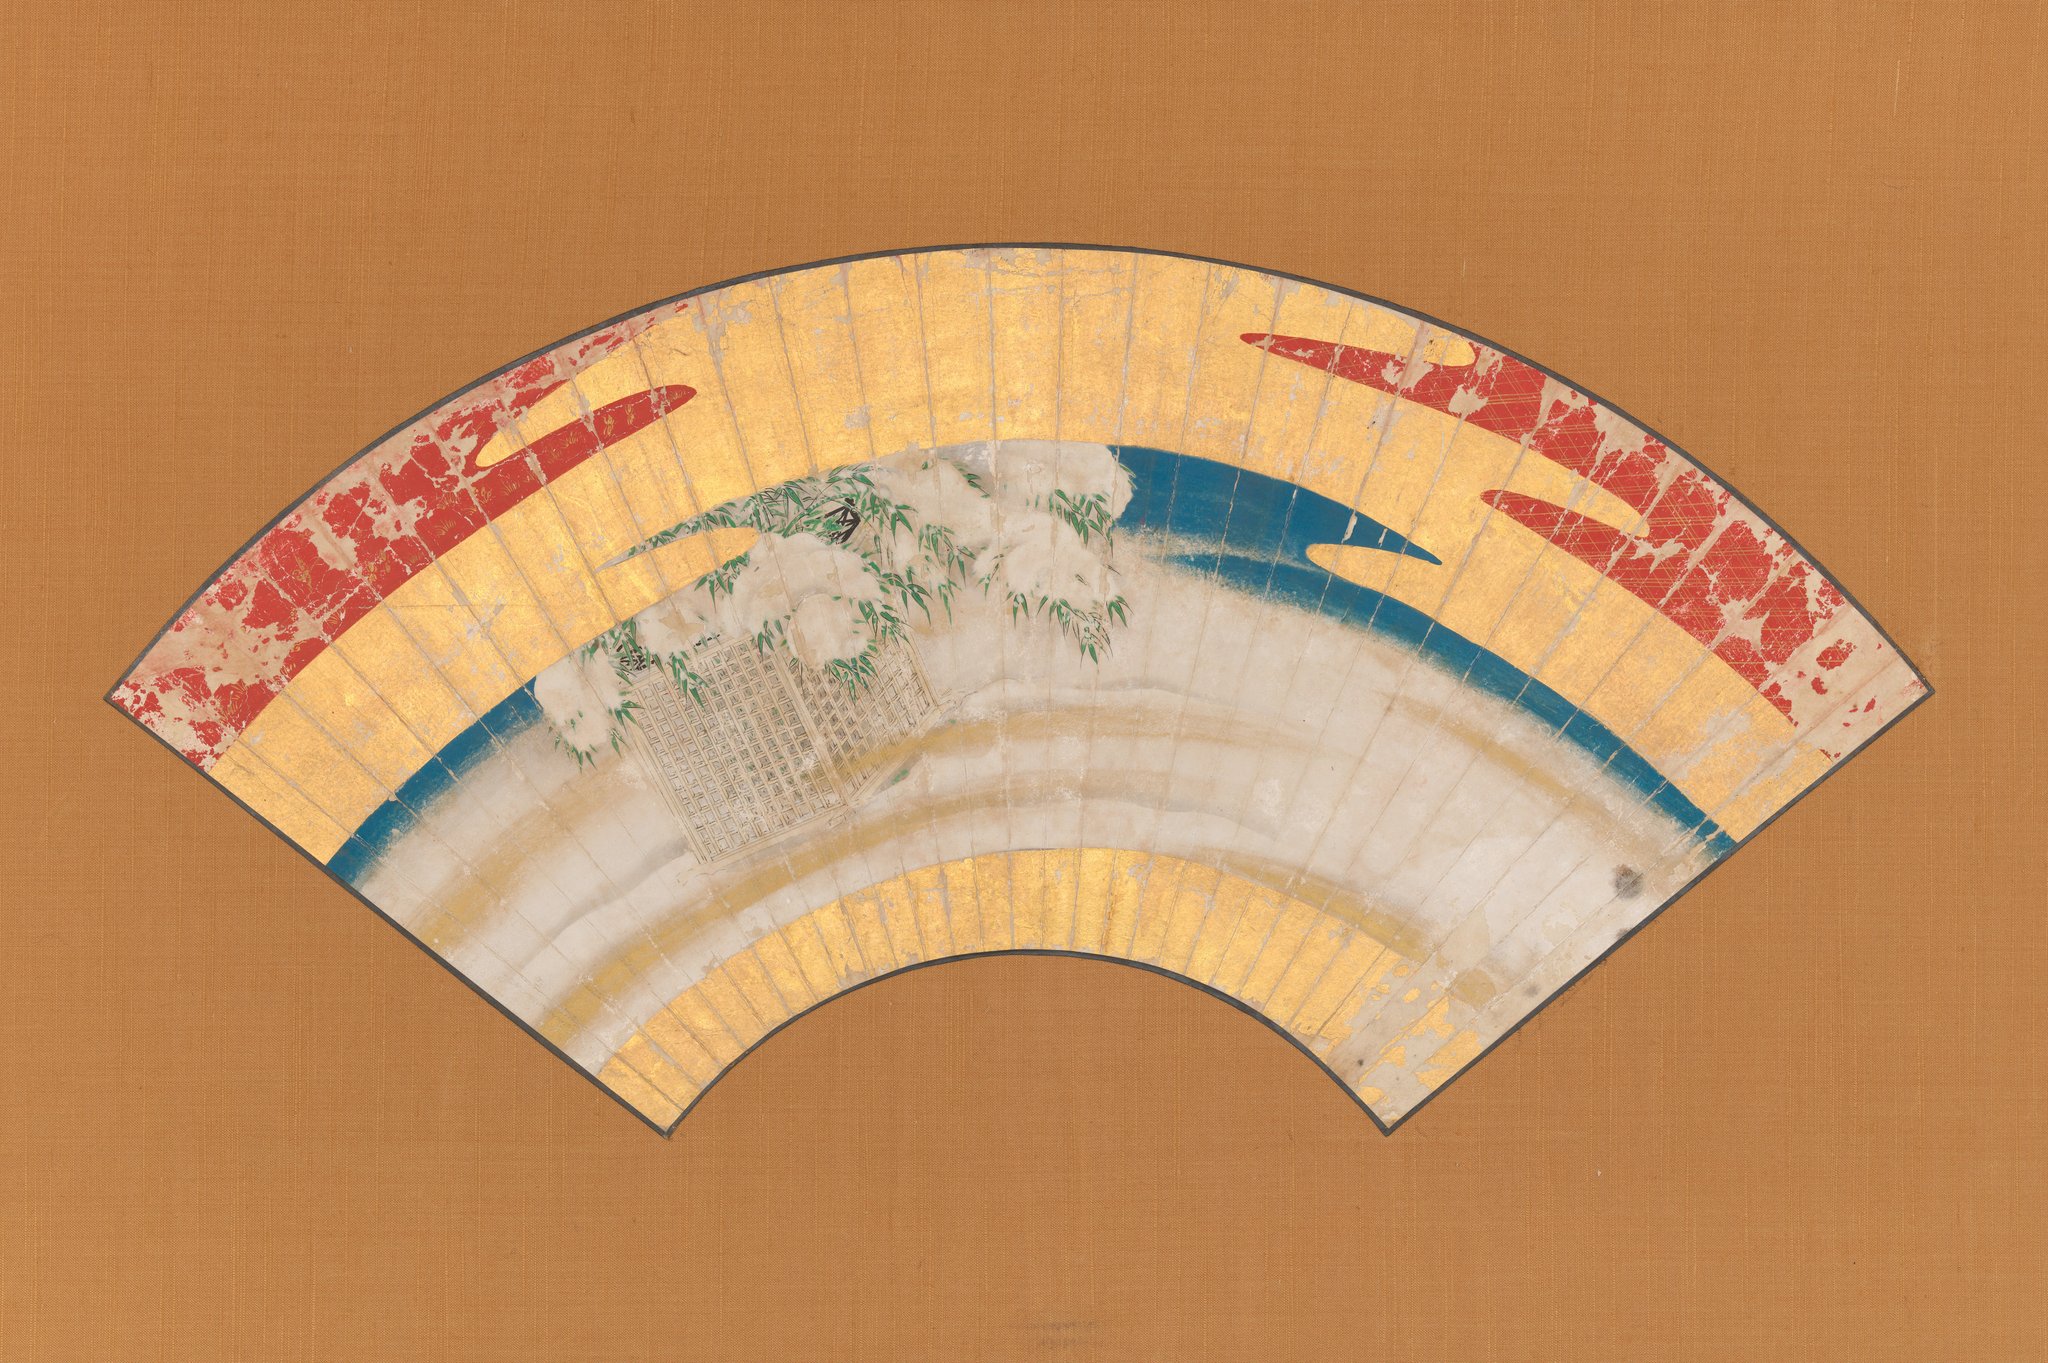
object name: painting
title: Breaking a Plum Branch on a Snowy Night; Bamboo in Snow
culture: japanese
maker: reizei tamechika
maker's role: artist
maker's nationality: japanese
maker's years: 1823-1864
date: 1801-1900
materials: gold, ink, panel, paper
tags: bamboo,snow